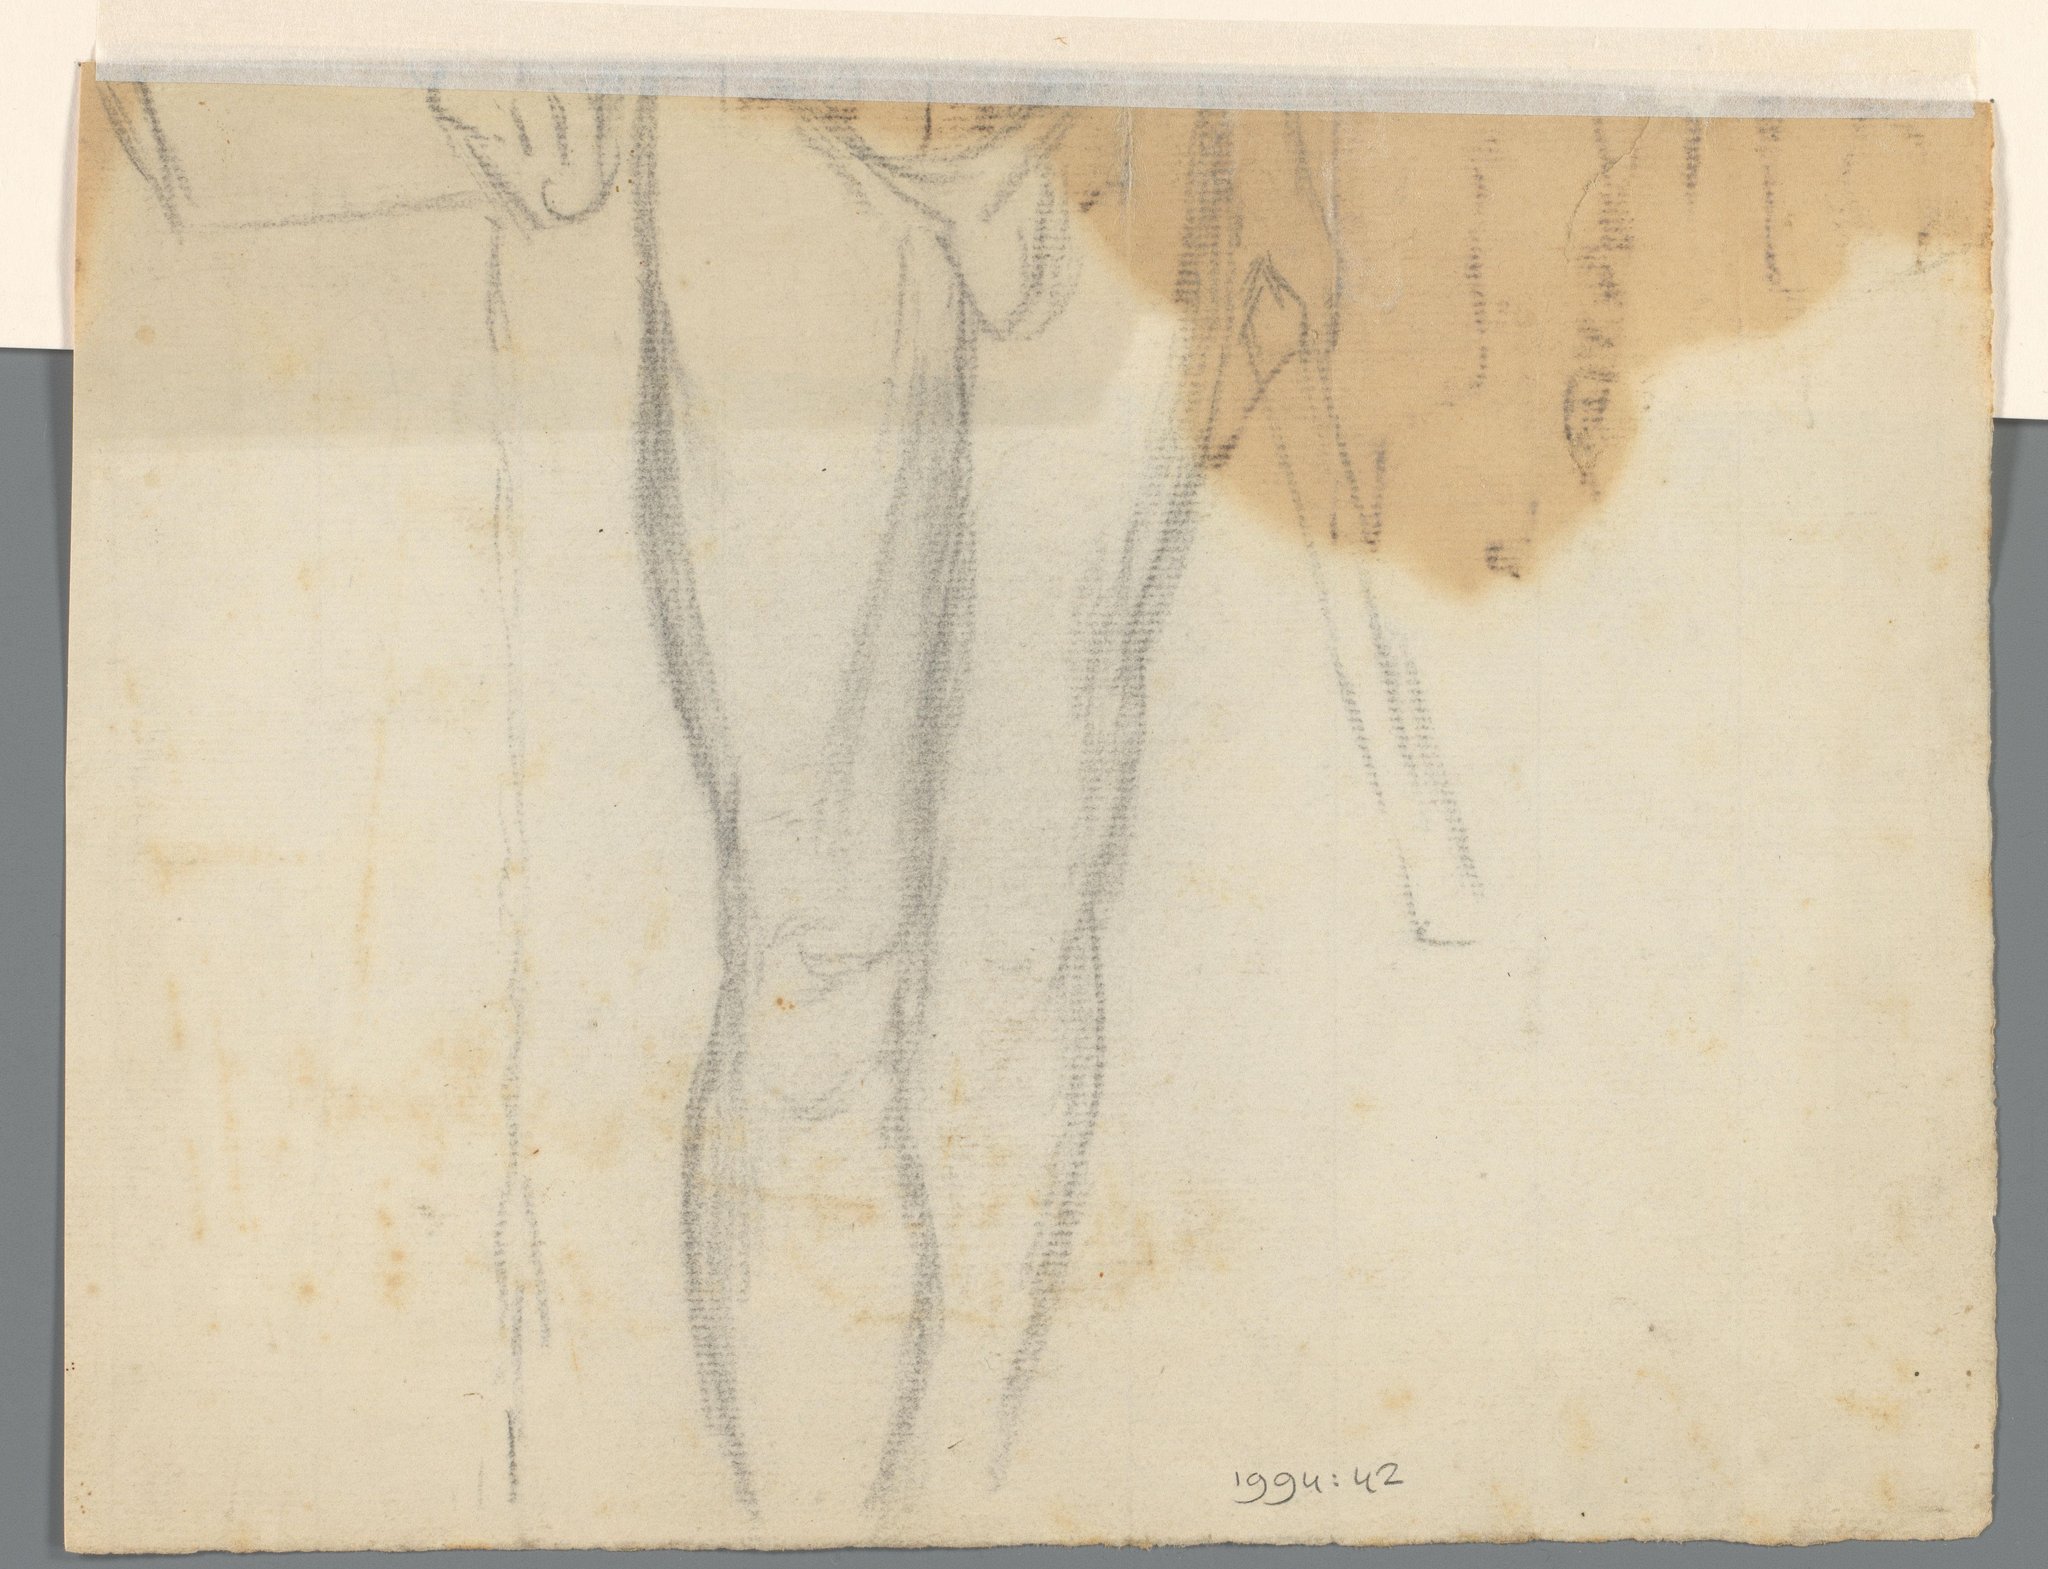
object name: drawing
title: Fragment van een staand mannelijk naakt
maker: johannes tavenraat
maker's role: draughtsman, painter, print maker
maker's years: 1809-1881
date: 1819-1881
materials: paper, pencil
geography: netherlands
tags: standing figure